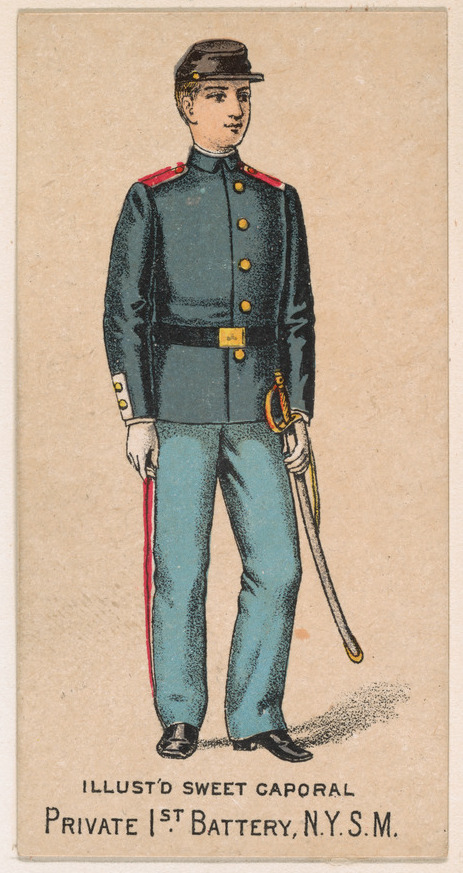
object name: print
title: Private, 1st Battery, New York State Militia, from the Military Series (N224) issued by Kinney Tobacco Company to promote Sweet Caporal Cigarettes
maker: kinney brothers tobacco company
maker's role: publisher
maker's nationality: american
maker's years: 1869-2011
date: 1888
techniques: color lithograph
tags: military,men